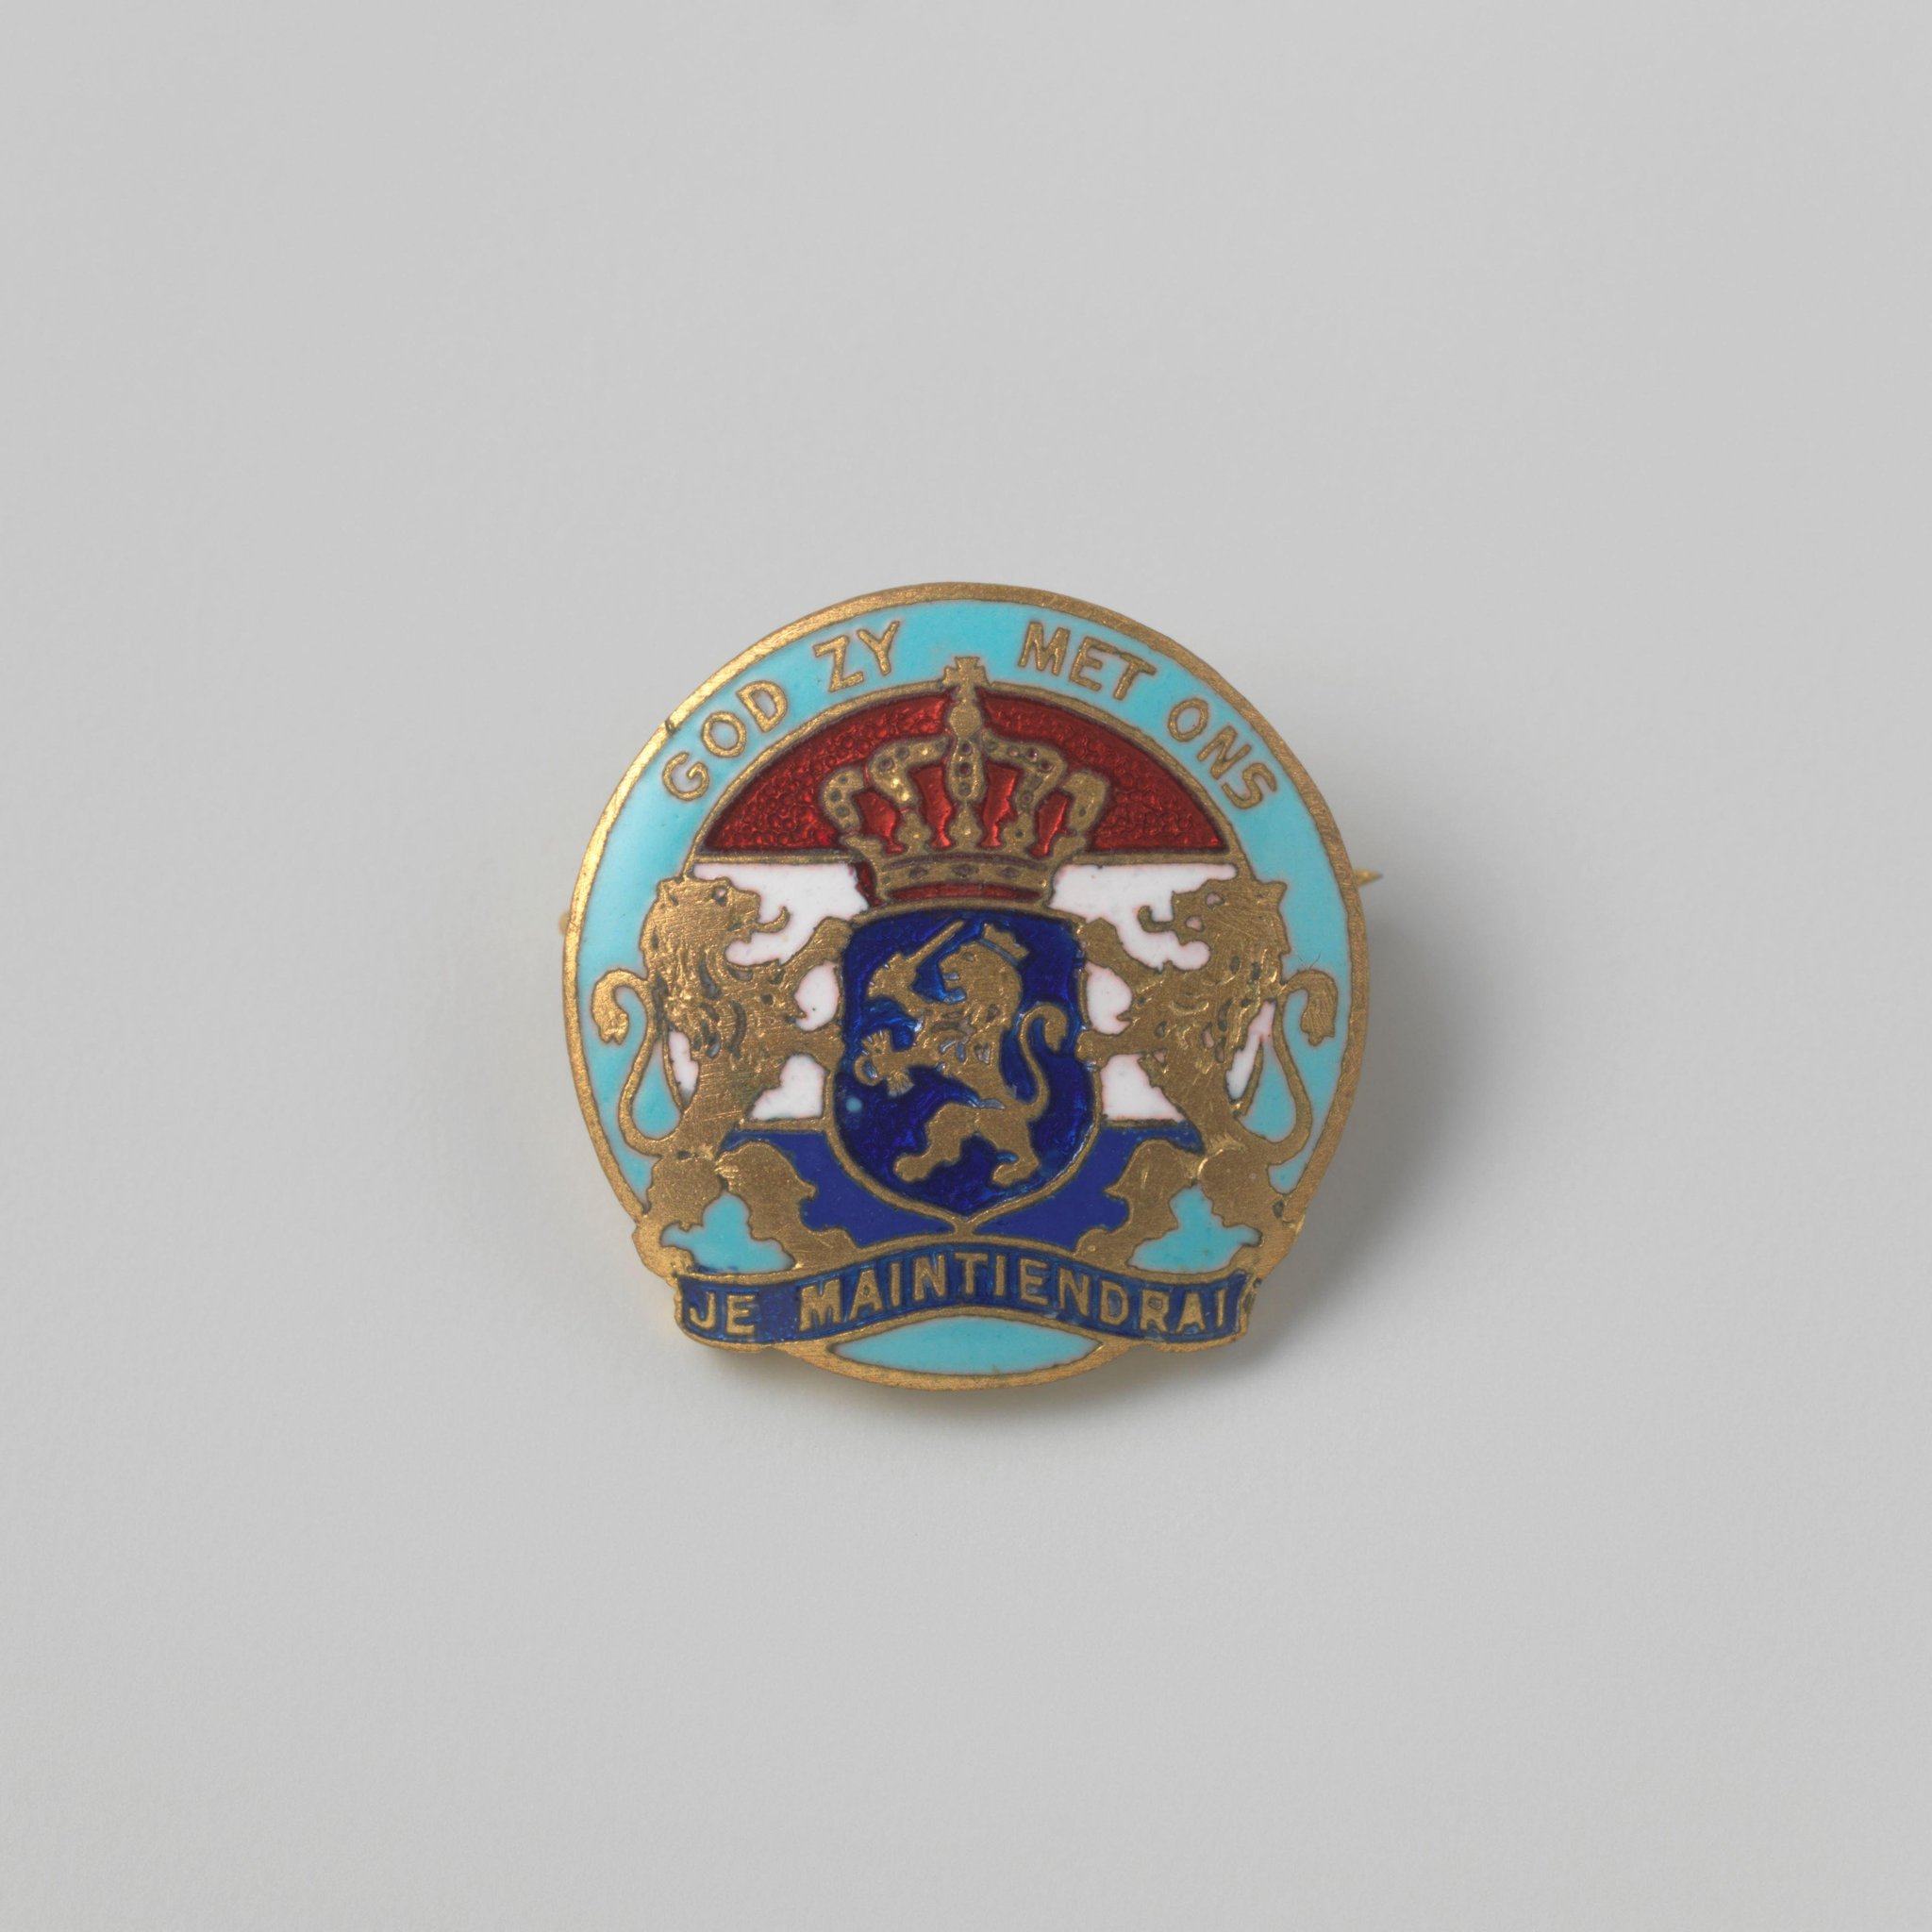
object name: brooch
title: Brooch with the Dutch coat of arms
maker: Anonymous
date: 1940-1945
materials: metal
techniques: enameling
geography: netherlands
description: Silent Resistance –War and Liberation Jewellery During the Second World War, small pieces of jewellery were worn in the Netherlands as a silent protest against the German occupier. In April 1941, Dutch coins were officially confiscated for the war industry. As jewellery did not have to be surrendered, coins were quickly transformed into rings, brooches, pins and bracelets. A portrait of Queen Wilhelmina was worn as a sign of resistance, as well as a token of loyalty to the royal family. Margriet Francisca, the third daughter of Princess Juliana and Prince Bernard, was born in Canada in January 1943. The pin with the three yellow chicks refers to the three young princesses Beatrix, Irene and Margriet and the steadfastness of the Dutch royal family. After the liberation, coins and silver were used for jewellery conveying messages of hope for a peaceful future.